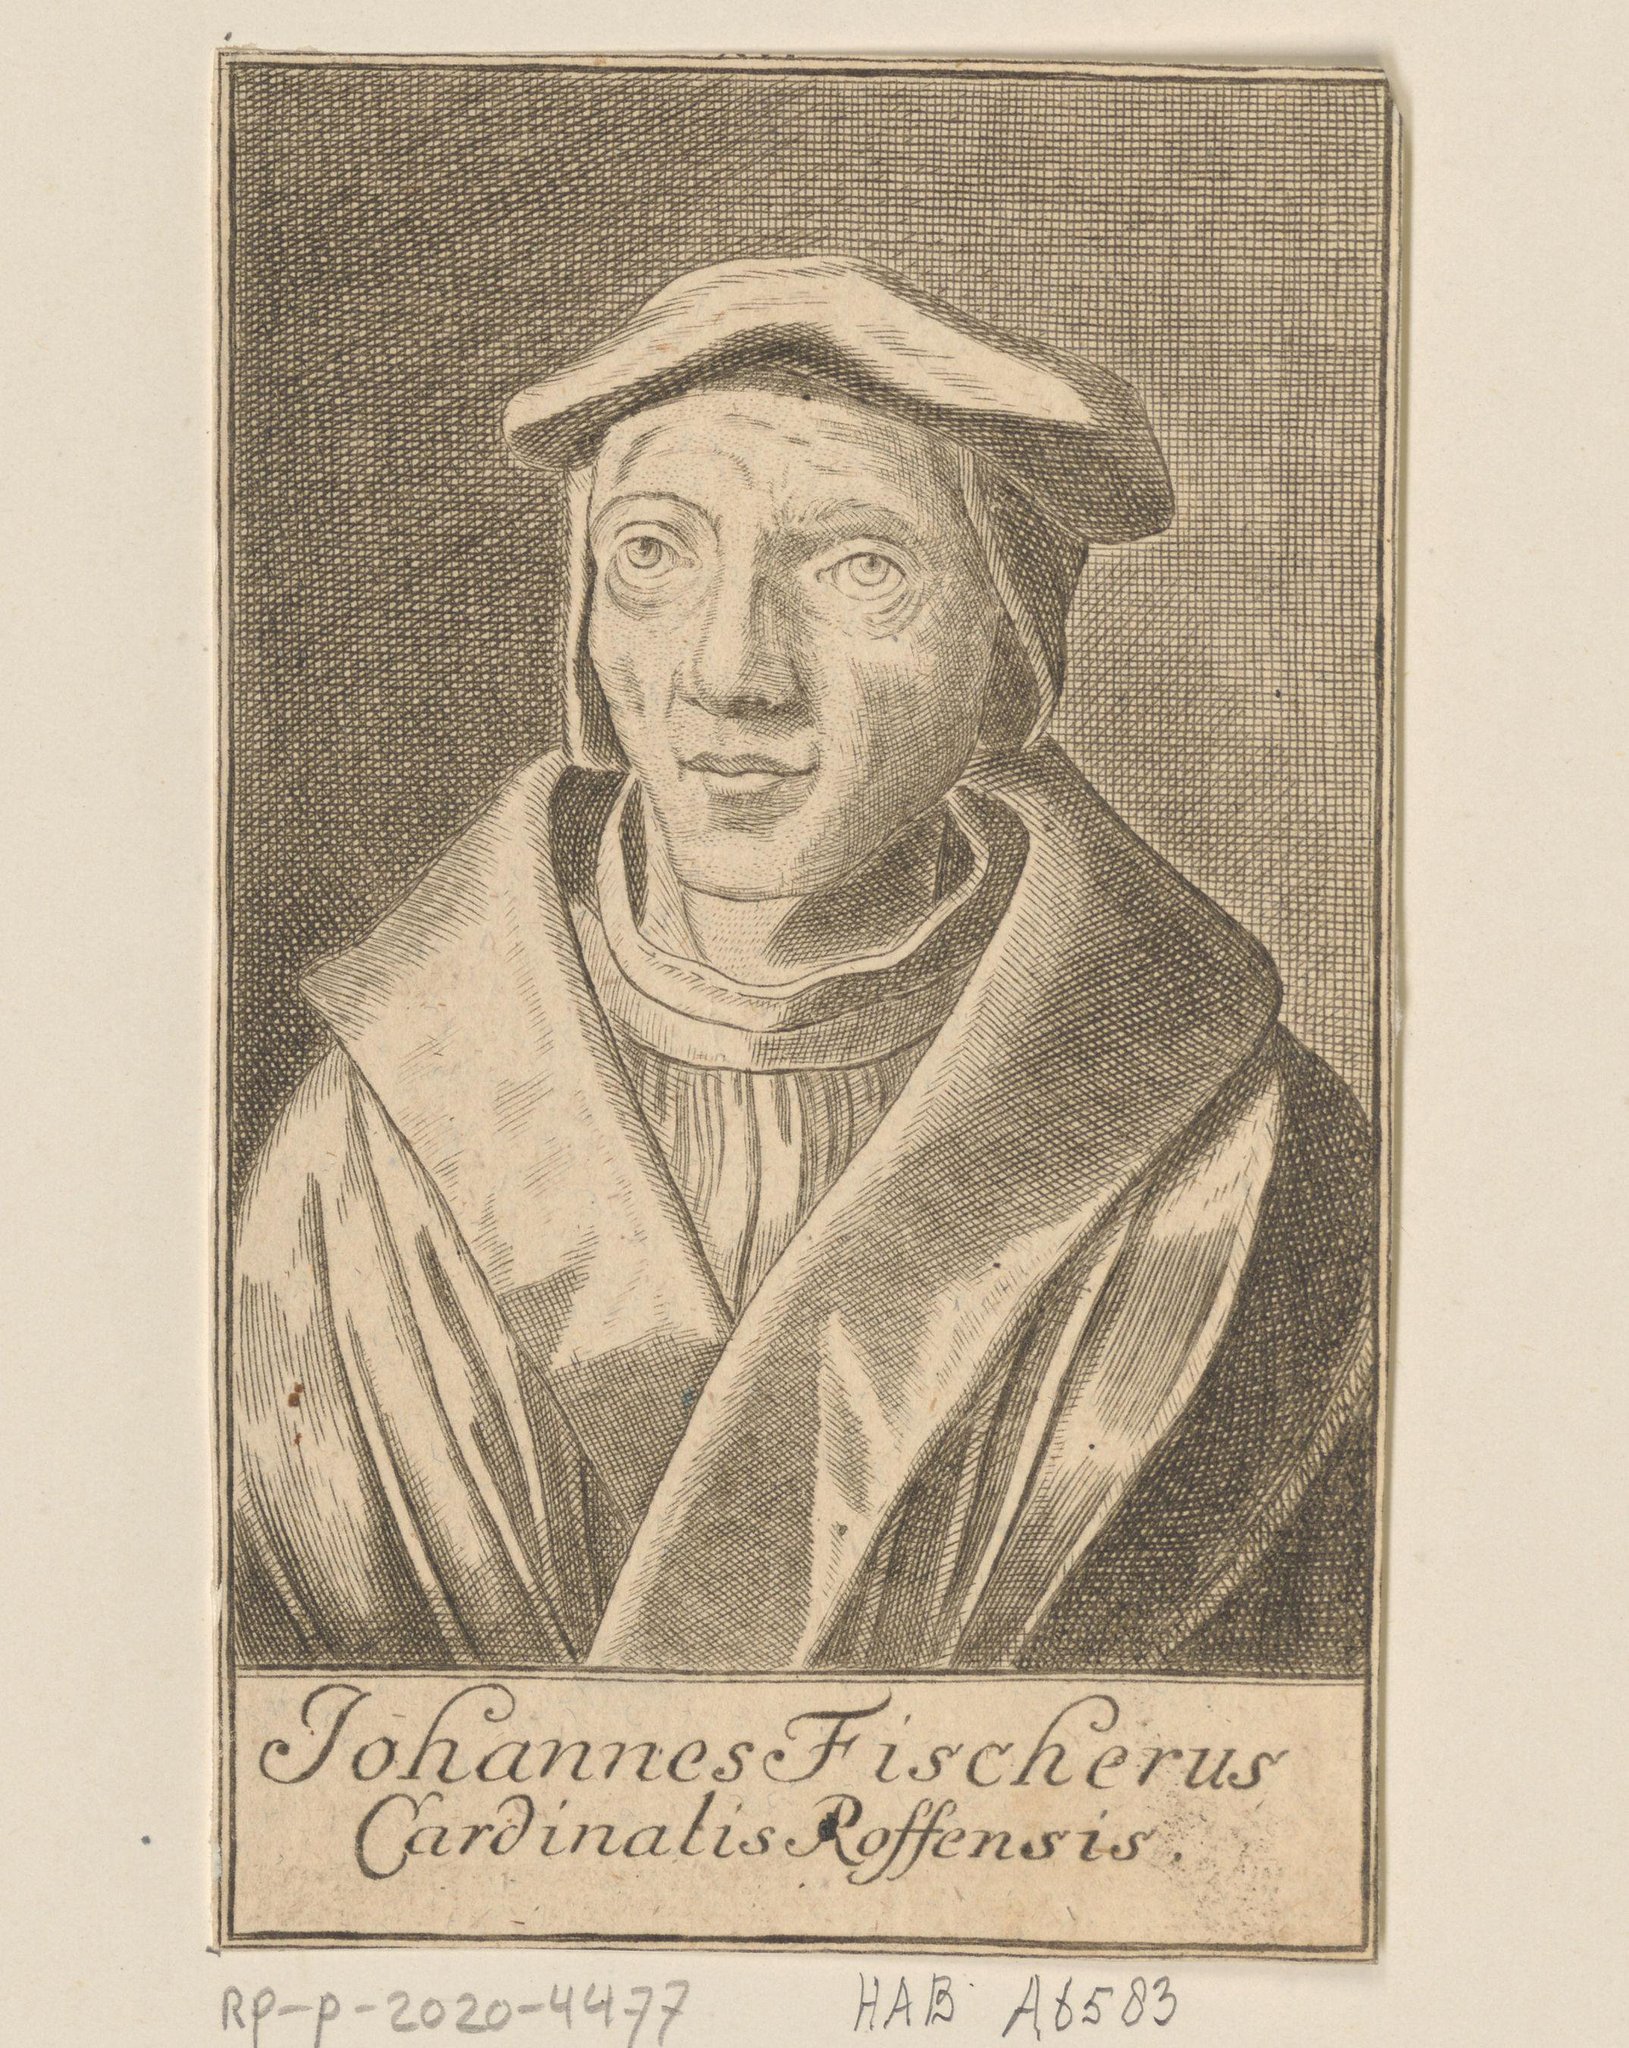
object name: book illustration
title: Portret van John Fisher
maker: Anonymous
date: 1724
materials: paper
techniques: engraving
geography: germany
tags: london, archbishop, bishop, etc. (roman catholic), historical persons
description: Prent waarschijnlijk uit: Fortgesetzte Sammlung von Alten und Neuen Theologischen Sachen (...) auff das Jahr 1724. Leipzig: erven Johann Friedrich Brauns, 1724.